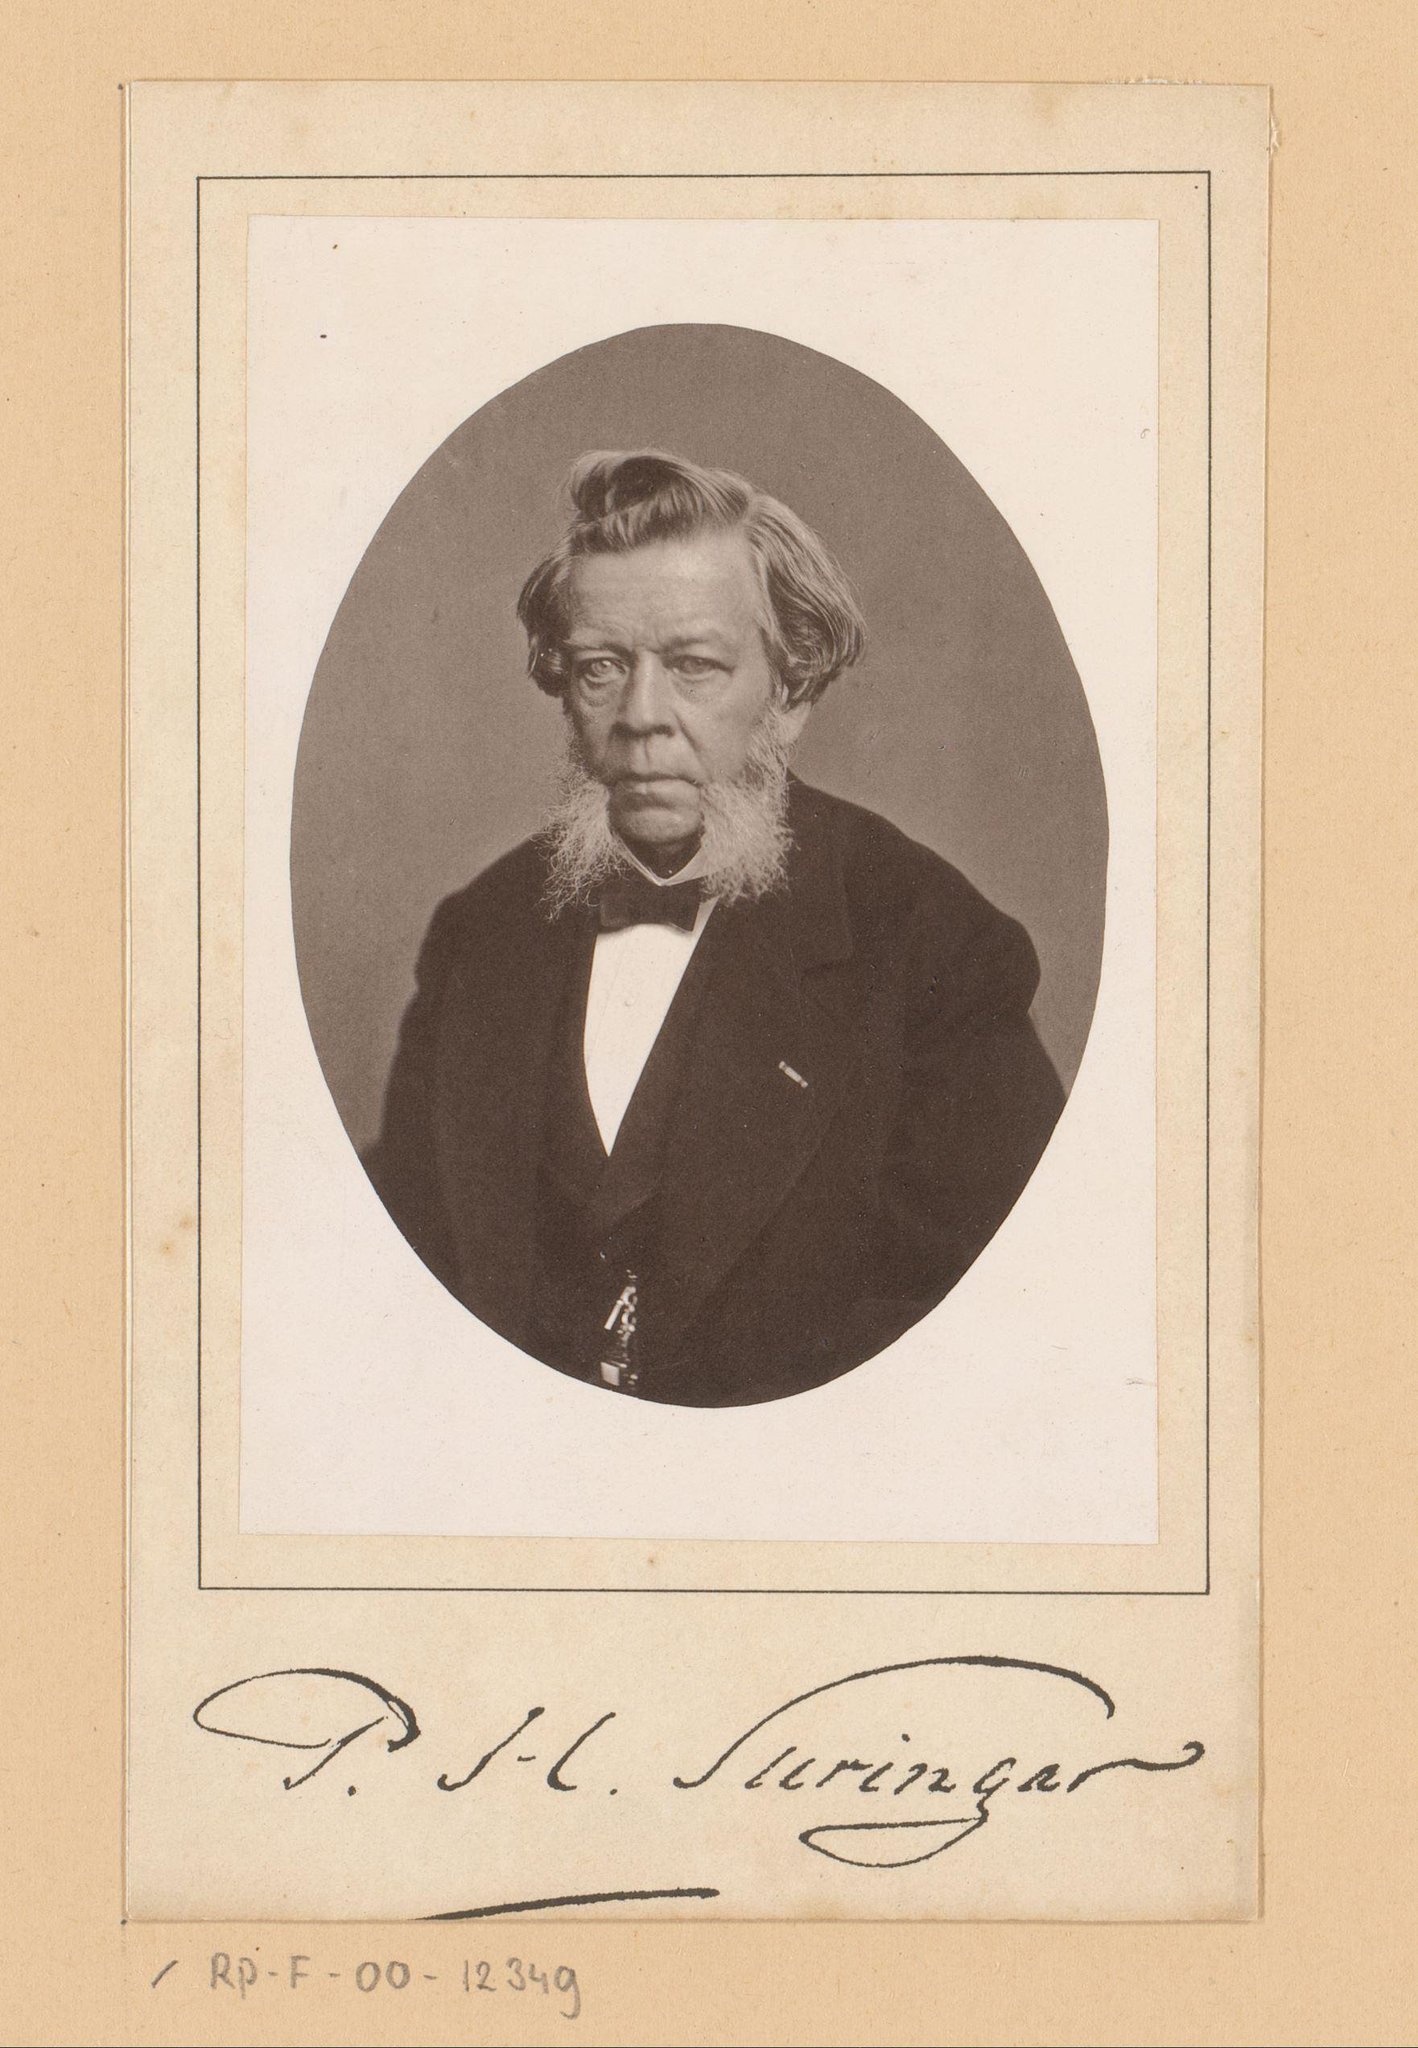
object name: photomechanical print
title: Portret van Pieter Hendrik Suringar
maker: Anonymous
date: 1880-1910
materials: cardboard, paper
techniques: photograph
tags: historical persons, portrait of a writer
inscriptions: inscription: ‘P.H. Suringar’